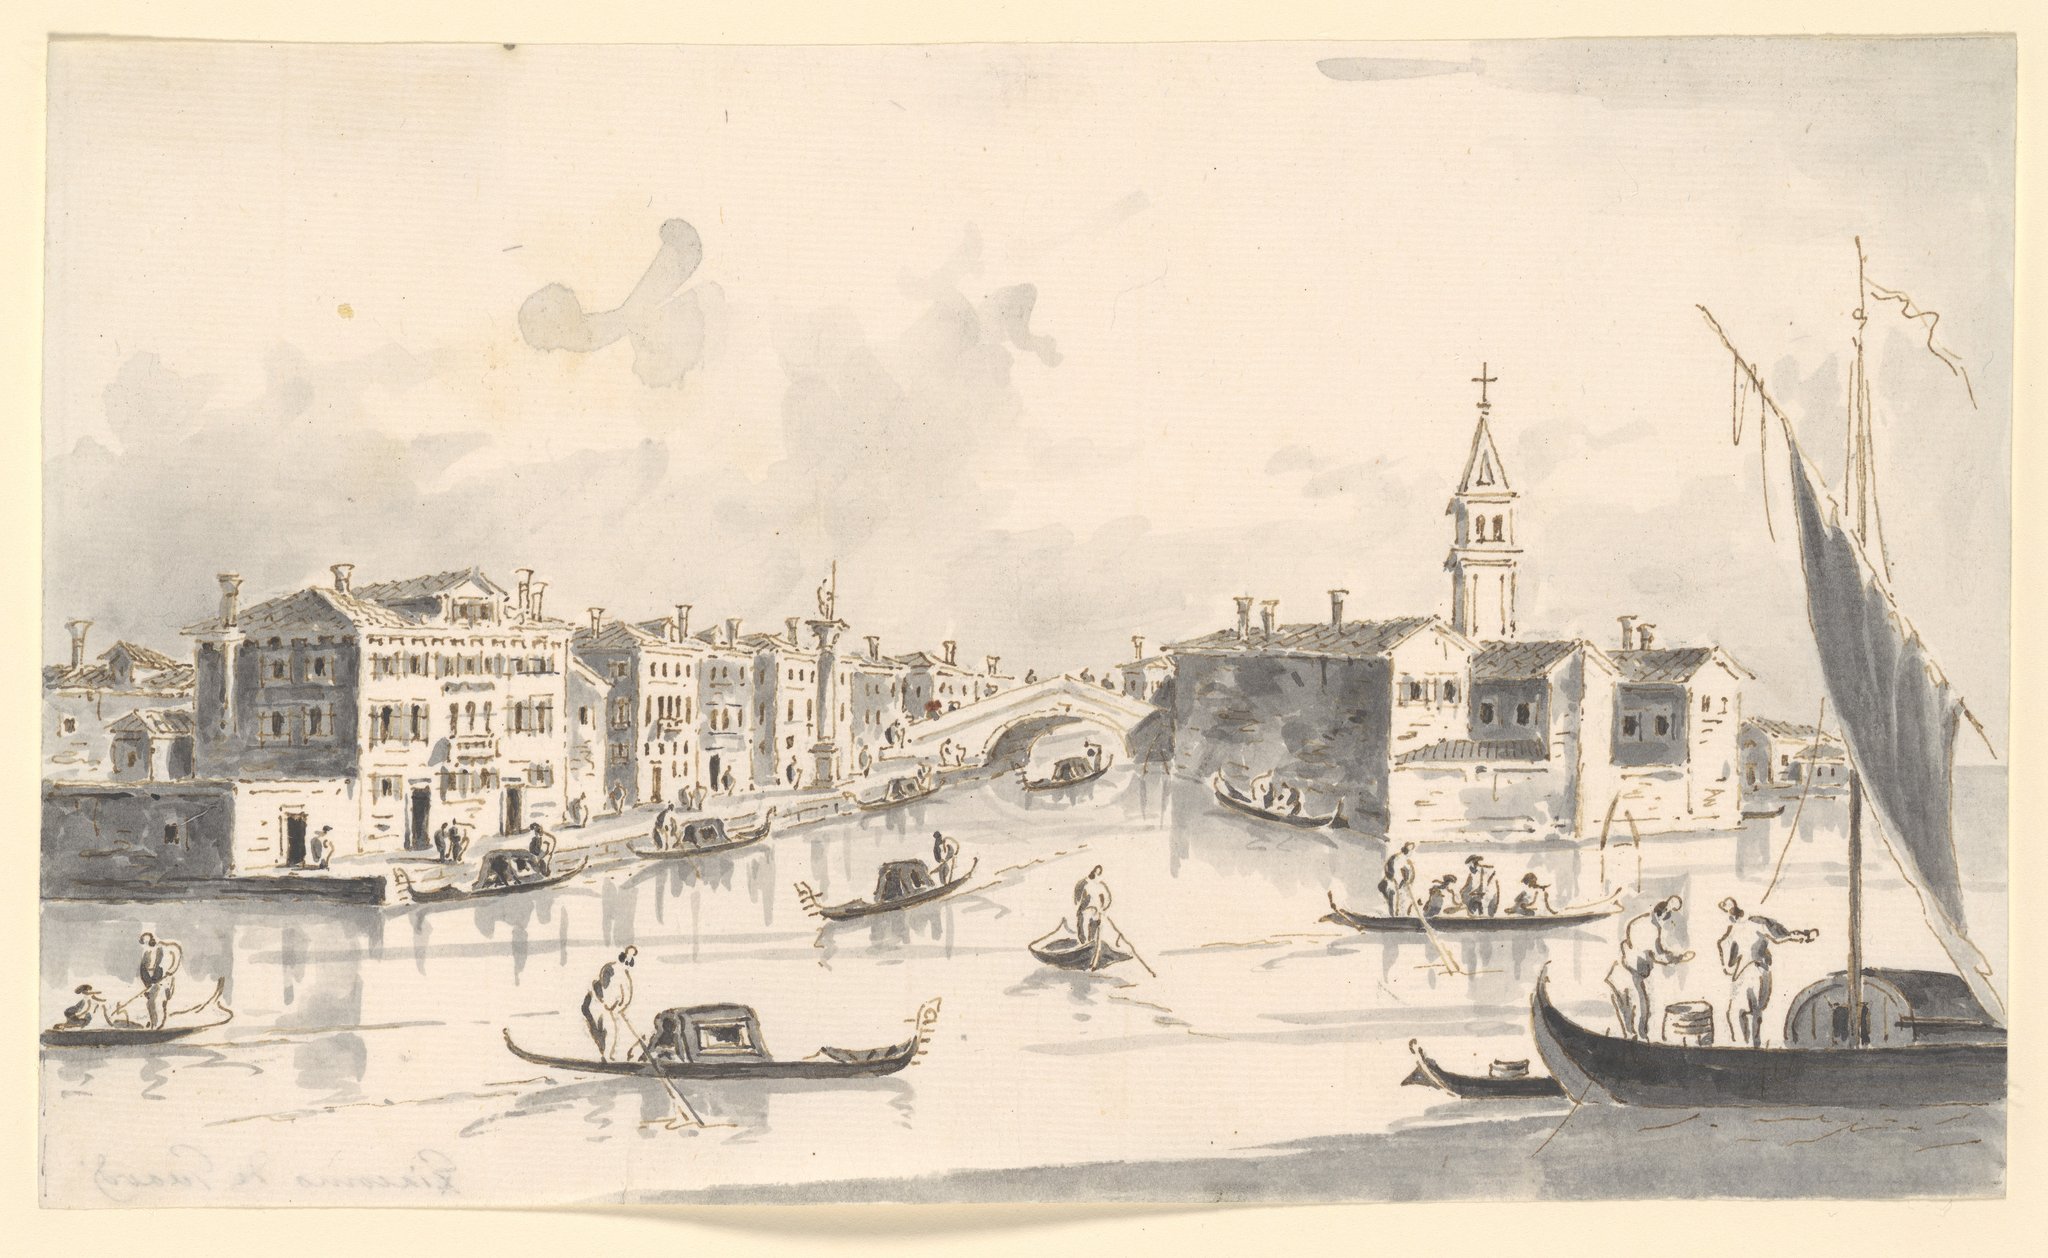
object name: drawing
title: View of Murano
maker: giacomo guardi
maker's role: artist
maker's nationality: italian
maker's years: 1764-1835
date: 1804-1828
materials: ink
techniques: pen, wash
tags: buildings,bridges,boats,venice